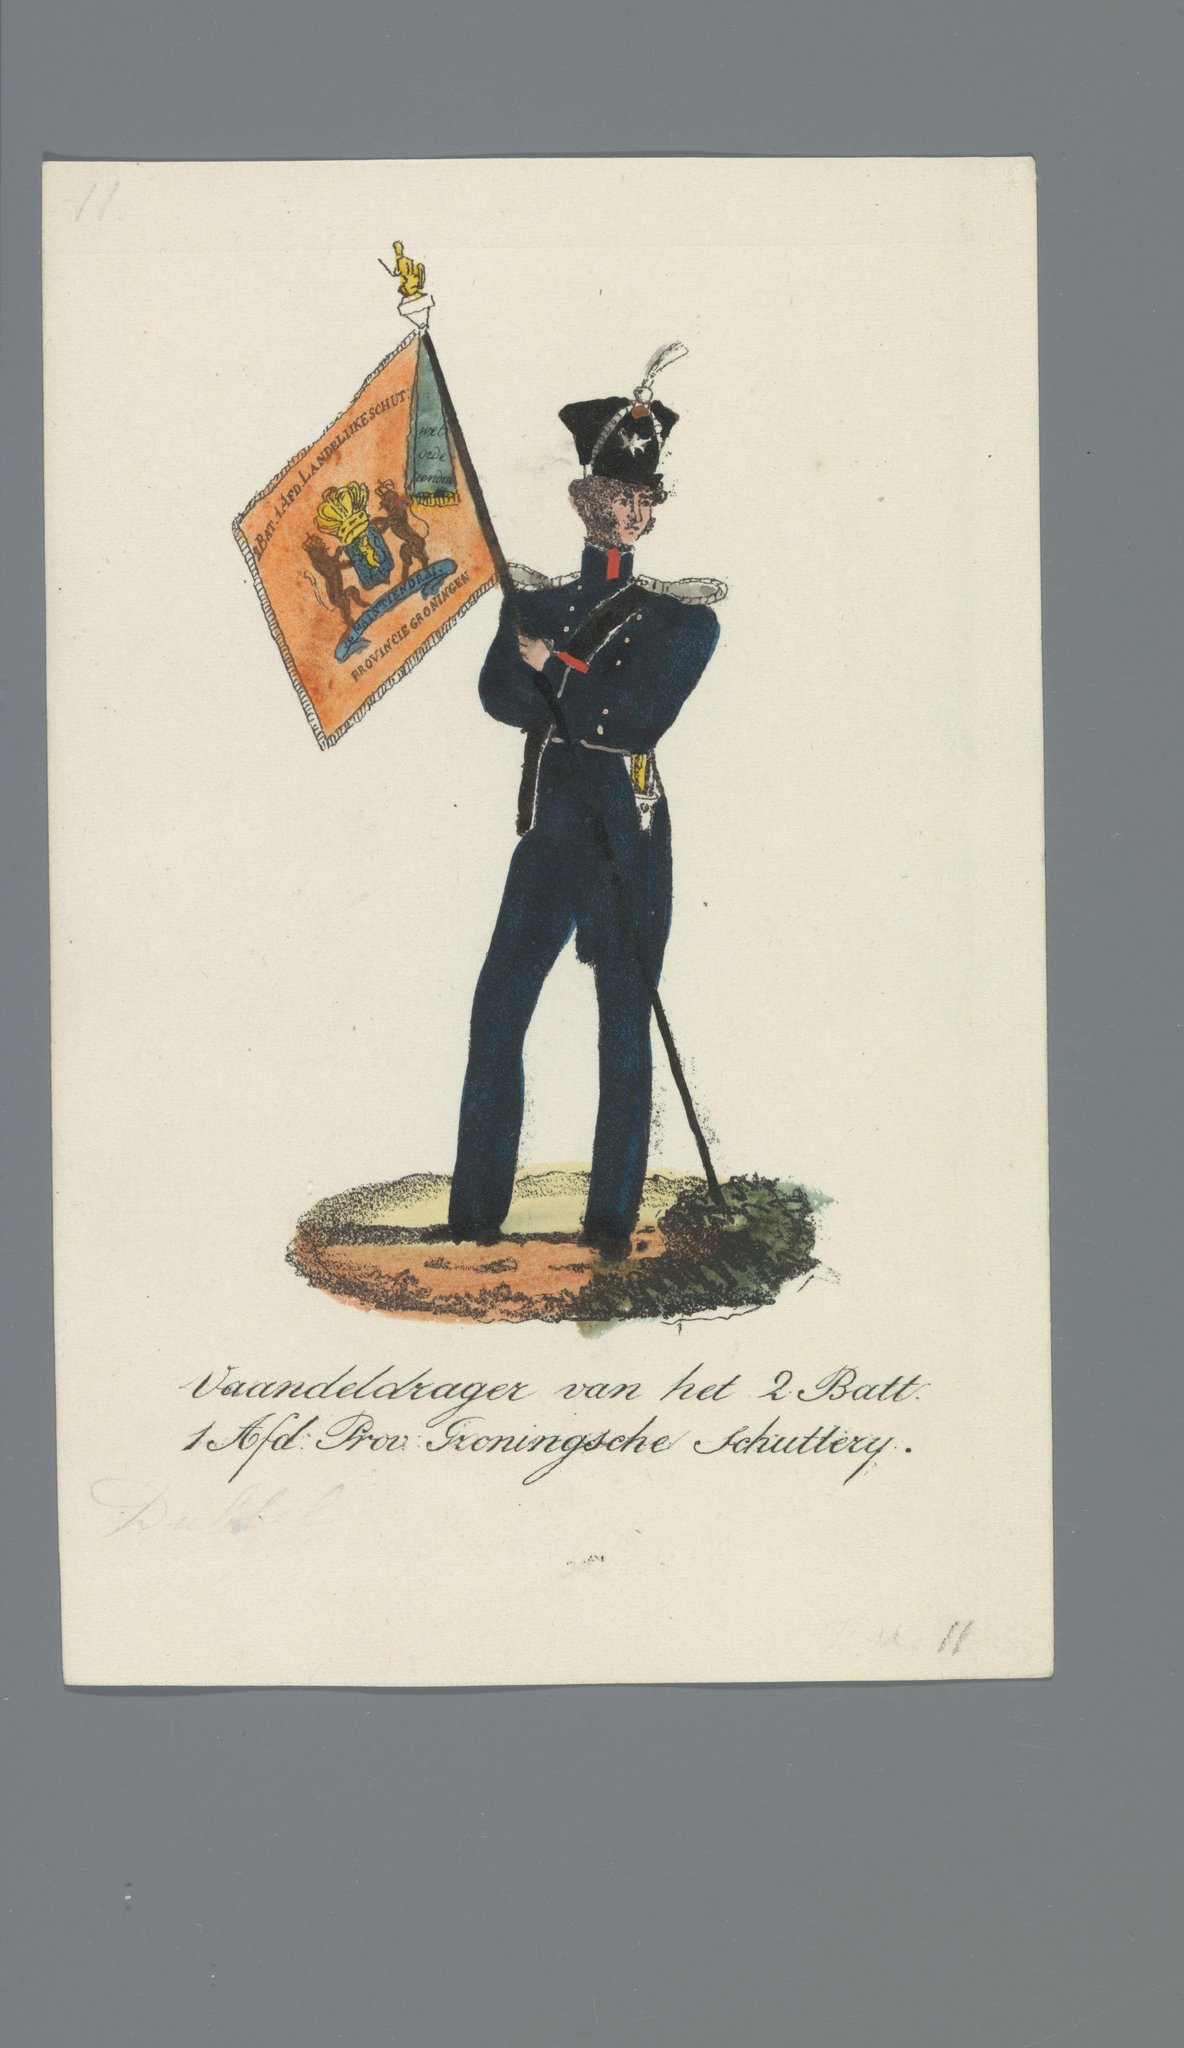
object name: costume print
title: Nederlandse militaire uniformen in de jaren 1830-1832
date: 1835-1850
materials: paper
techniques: hand coloring, lithograph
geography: utrecht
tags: standard-bearer, flag-bearer, (military) uniforms, clothes, costume, groningen (province)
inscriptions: collector's mark: Lugt 2228, collector's mark: Lugt 2227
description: Staande schutter, vaandeldrager met het vaandel van het 2e Bataljon 1e Afdeling Provinciale Schutterij van Groningen. Onderdeel van een serie van 157 losse bladen met Nederlandse militaire uniformen in de jaren 1830-1832.